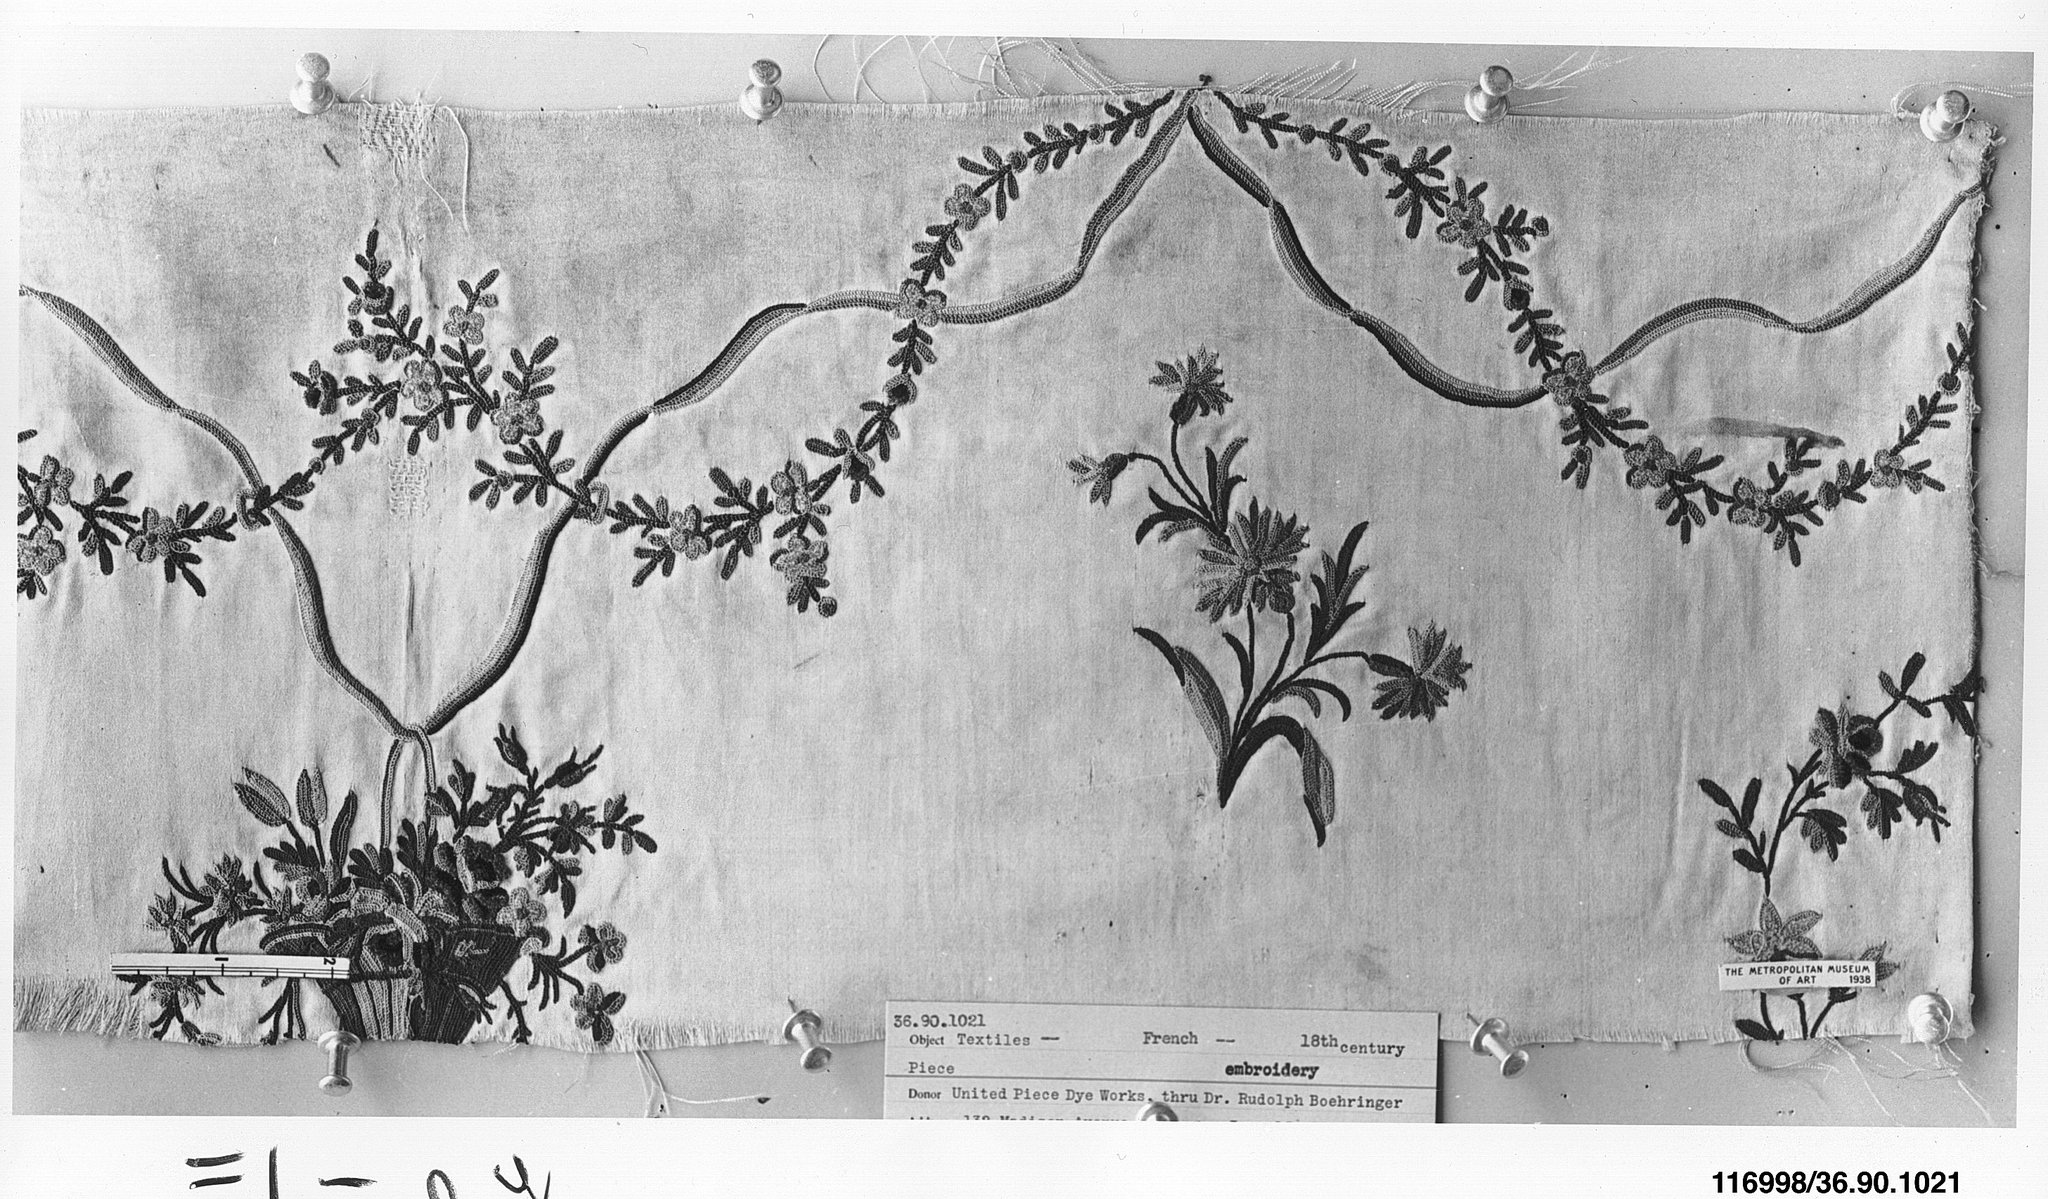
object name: piece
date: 1701-1800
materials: silk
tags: flowers,leaves